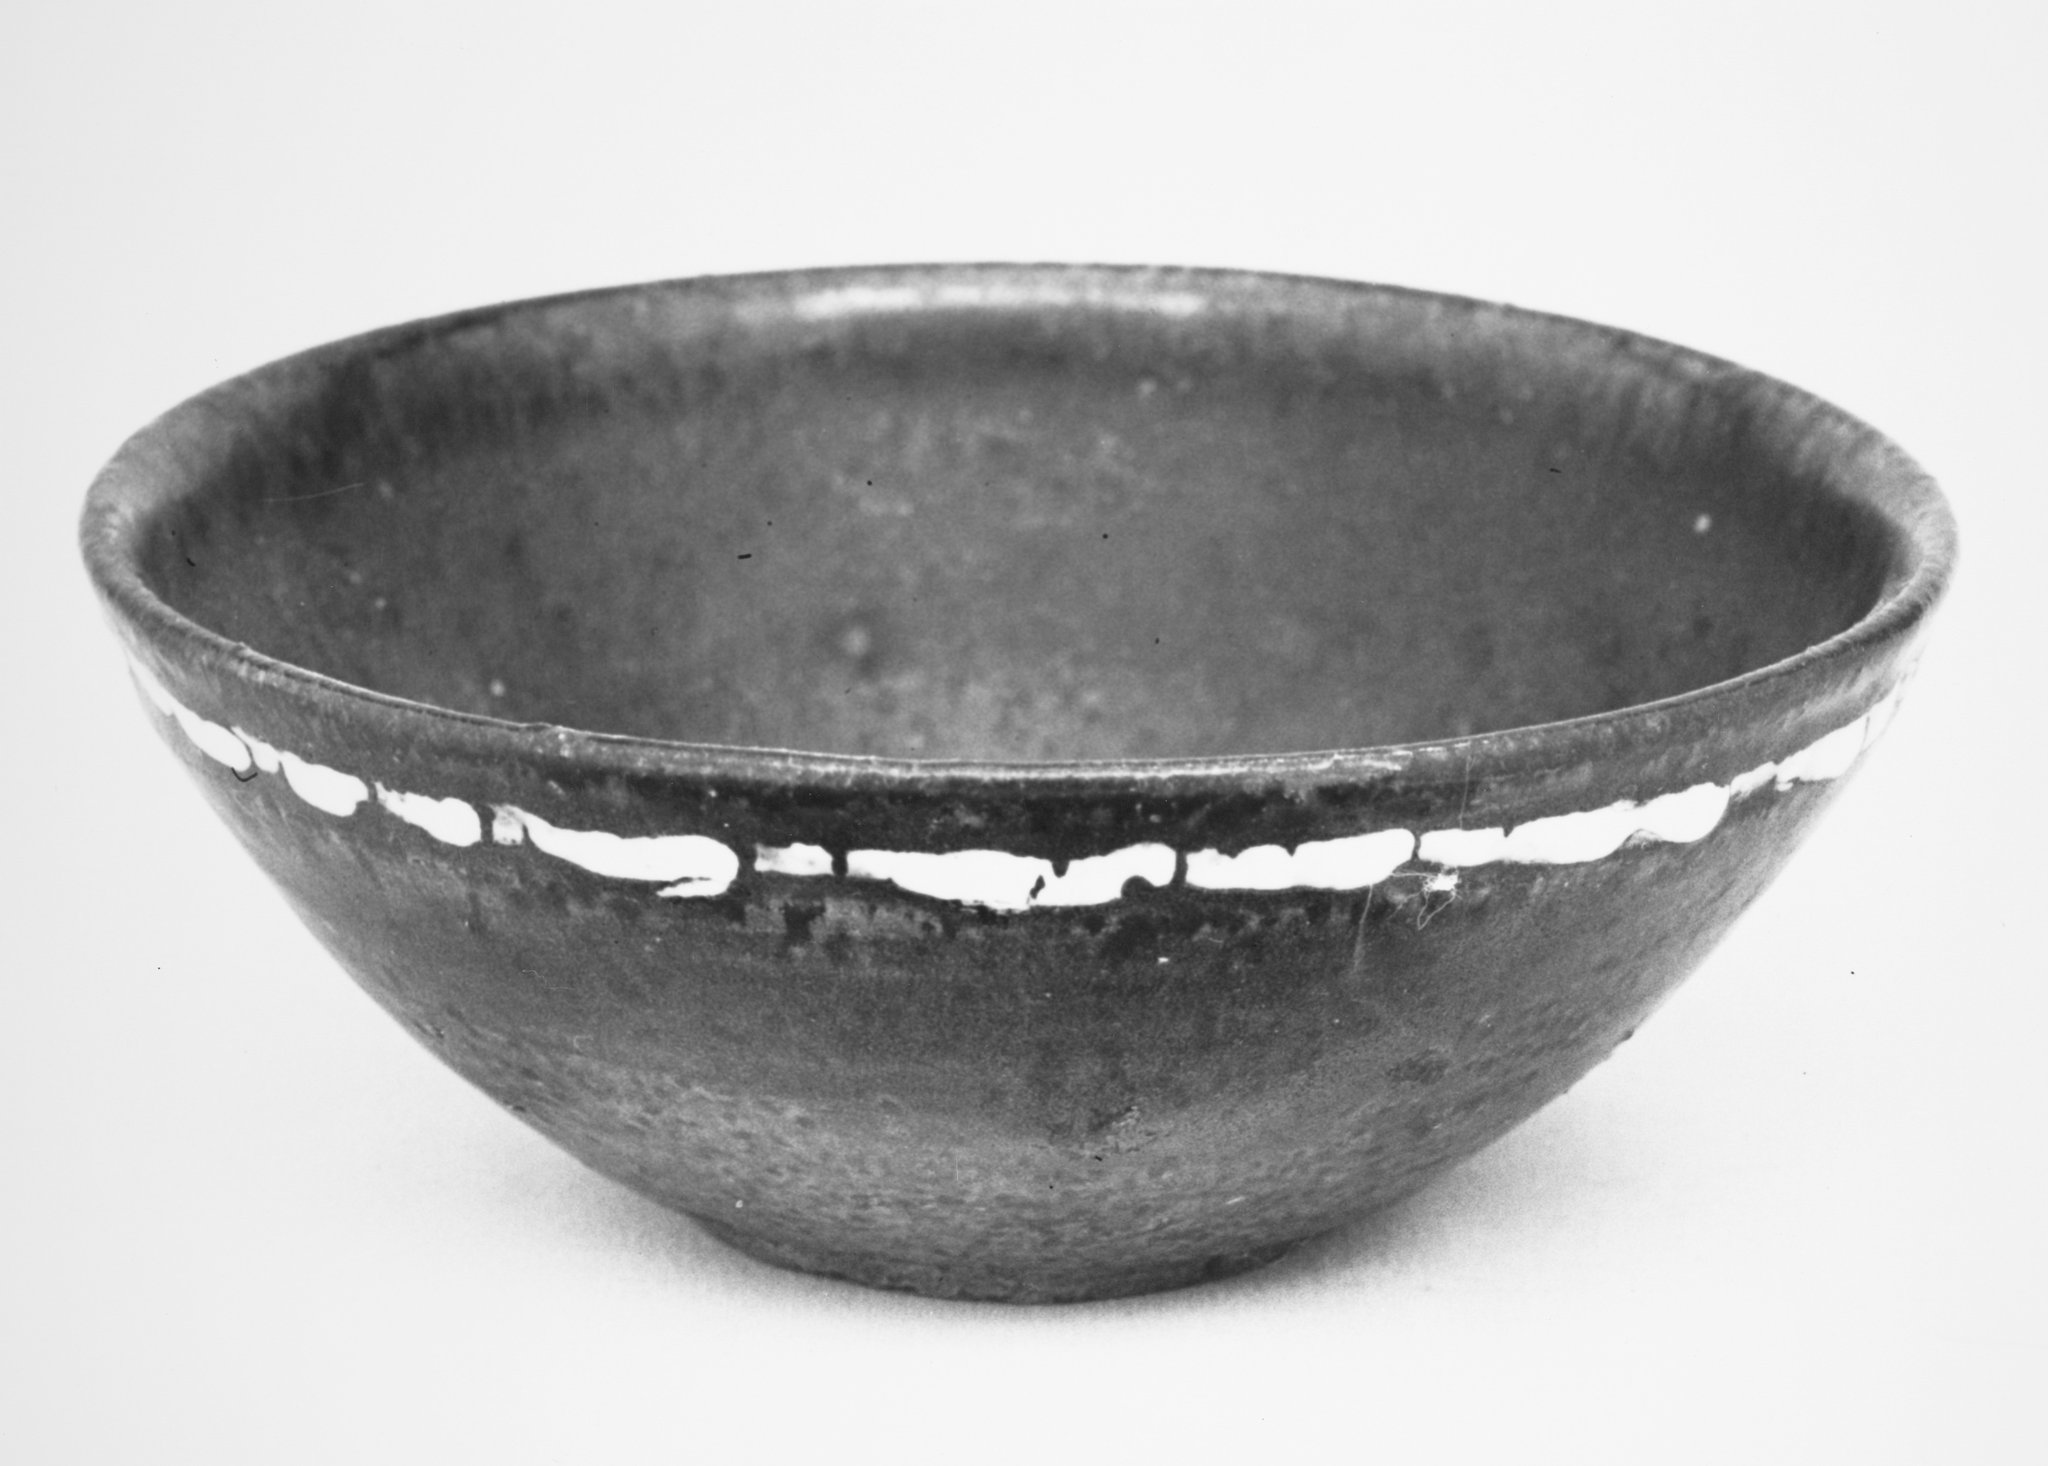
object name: teabowl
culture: japanese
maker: nonomura ninsei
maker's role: artist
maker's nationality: japanese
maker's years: 1646-1694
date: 1701-1800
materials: clay, enamel, glaze